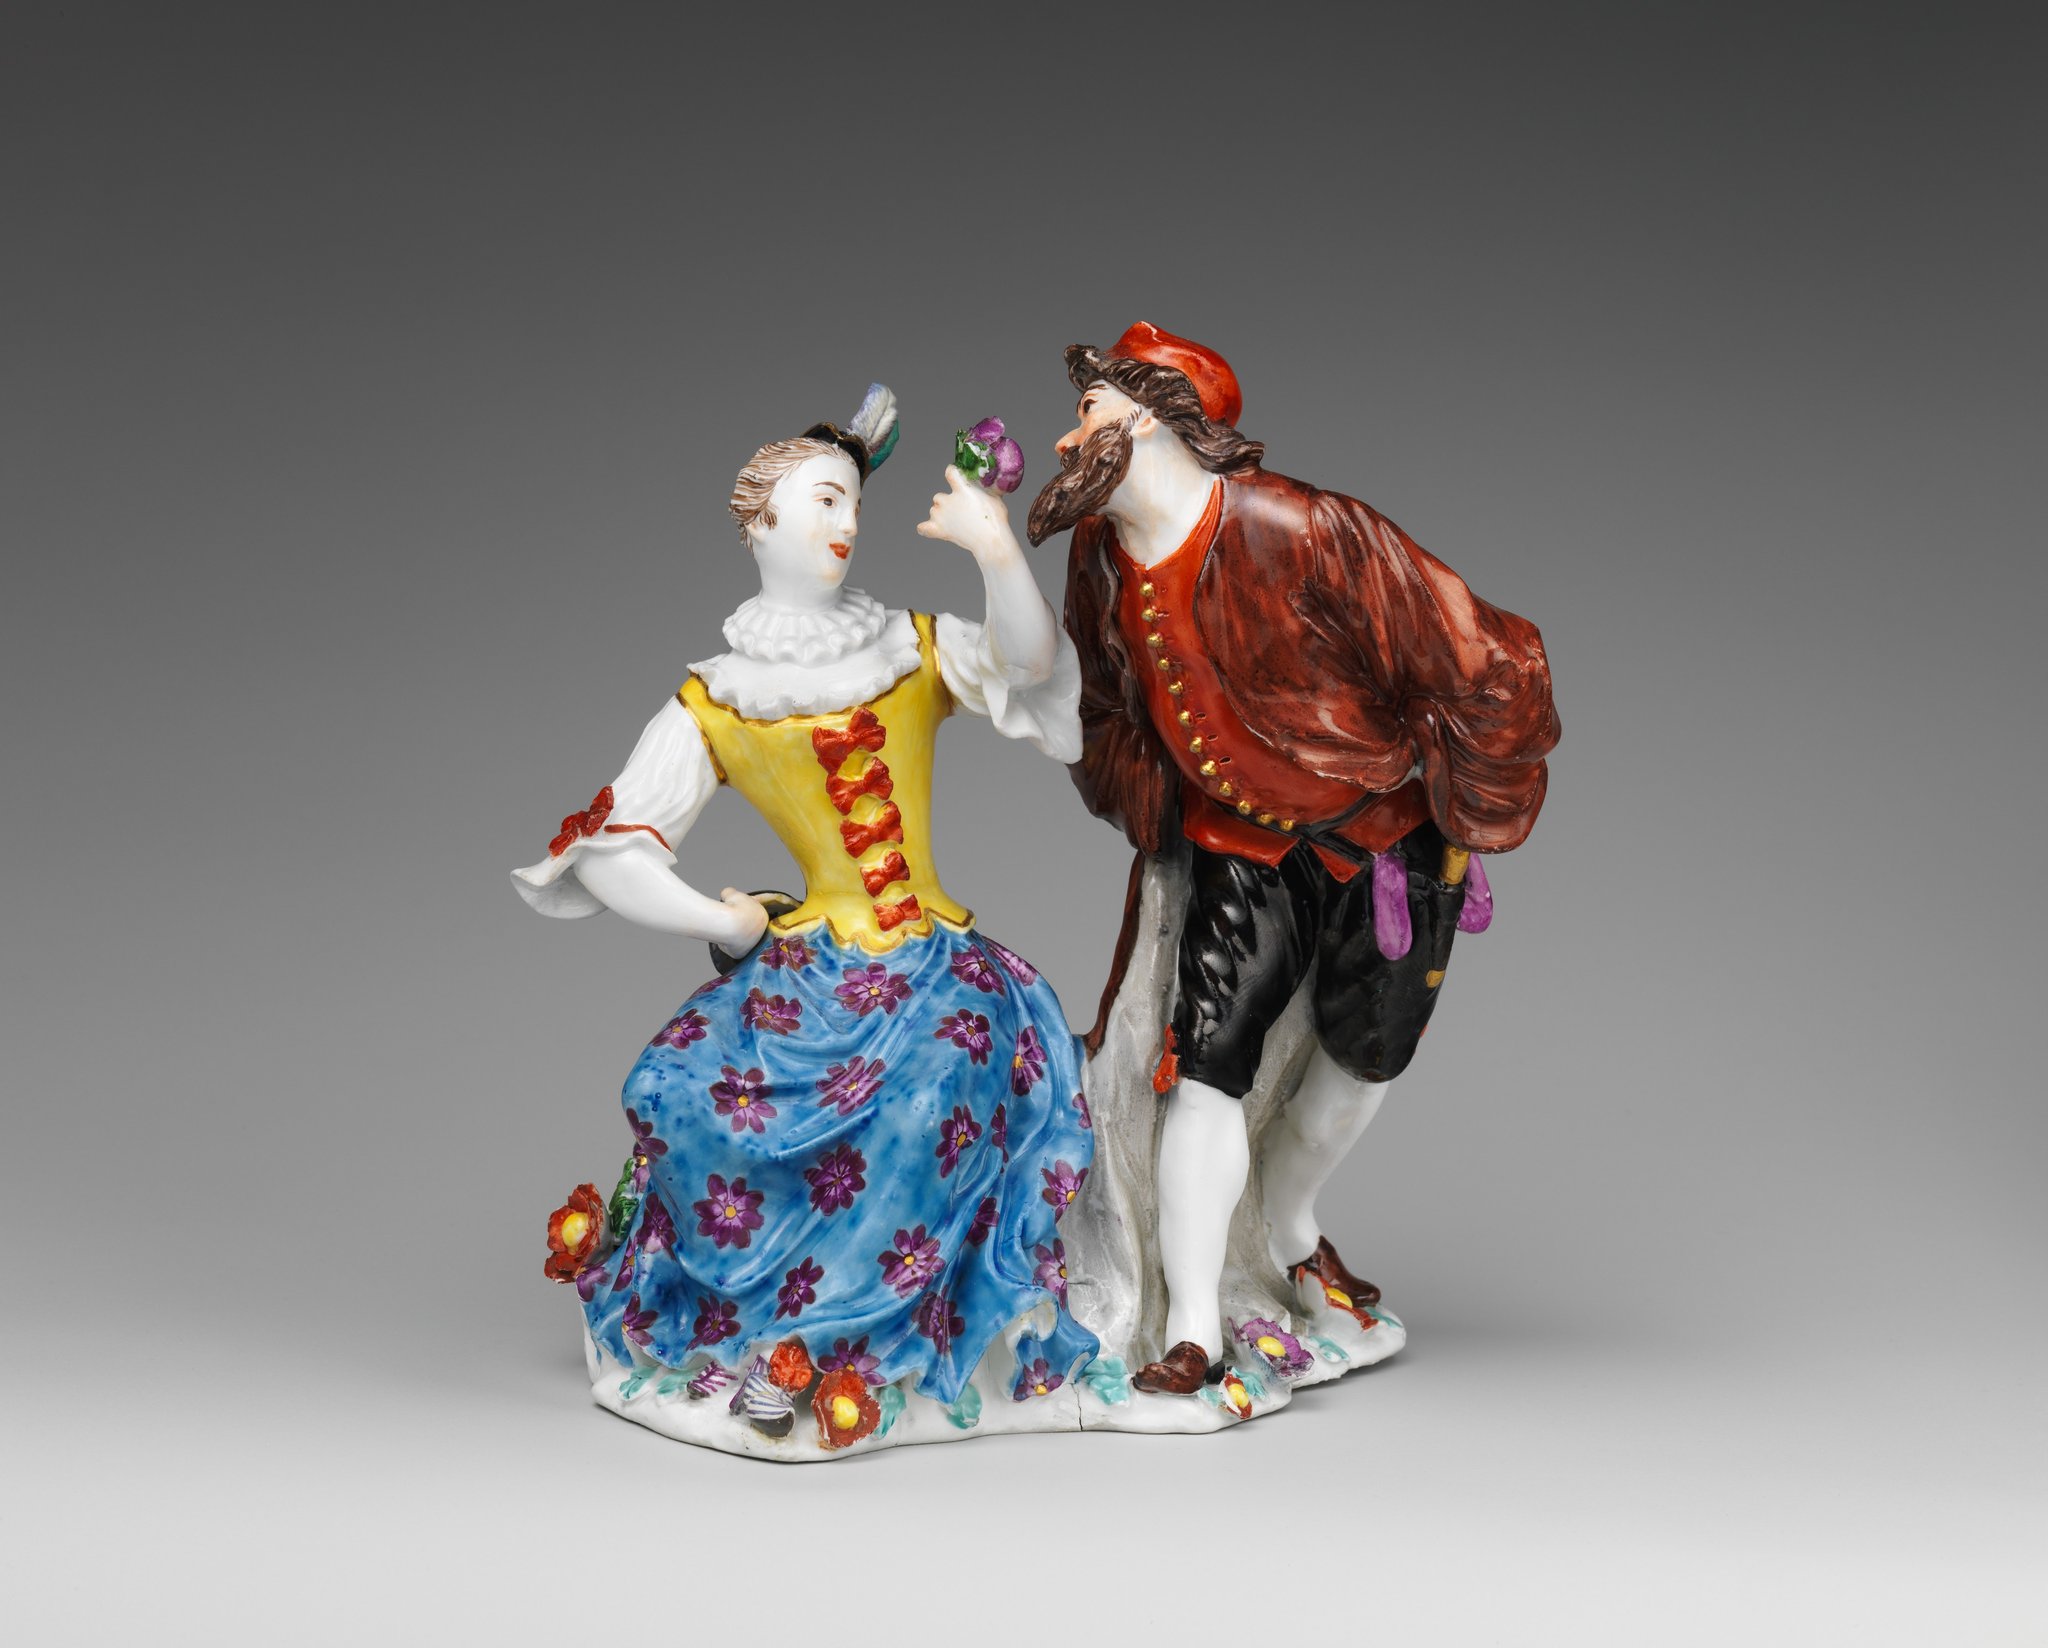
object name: group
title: Columbine and Pantalone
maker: meissen manufactory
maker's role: manufactory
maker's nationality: german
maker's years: 1710-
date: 1736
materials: enamel, gold, hard paste porcelain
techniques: polychrome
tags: men,women